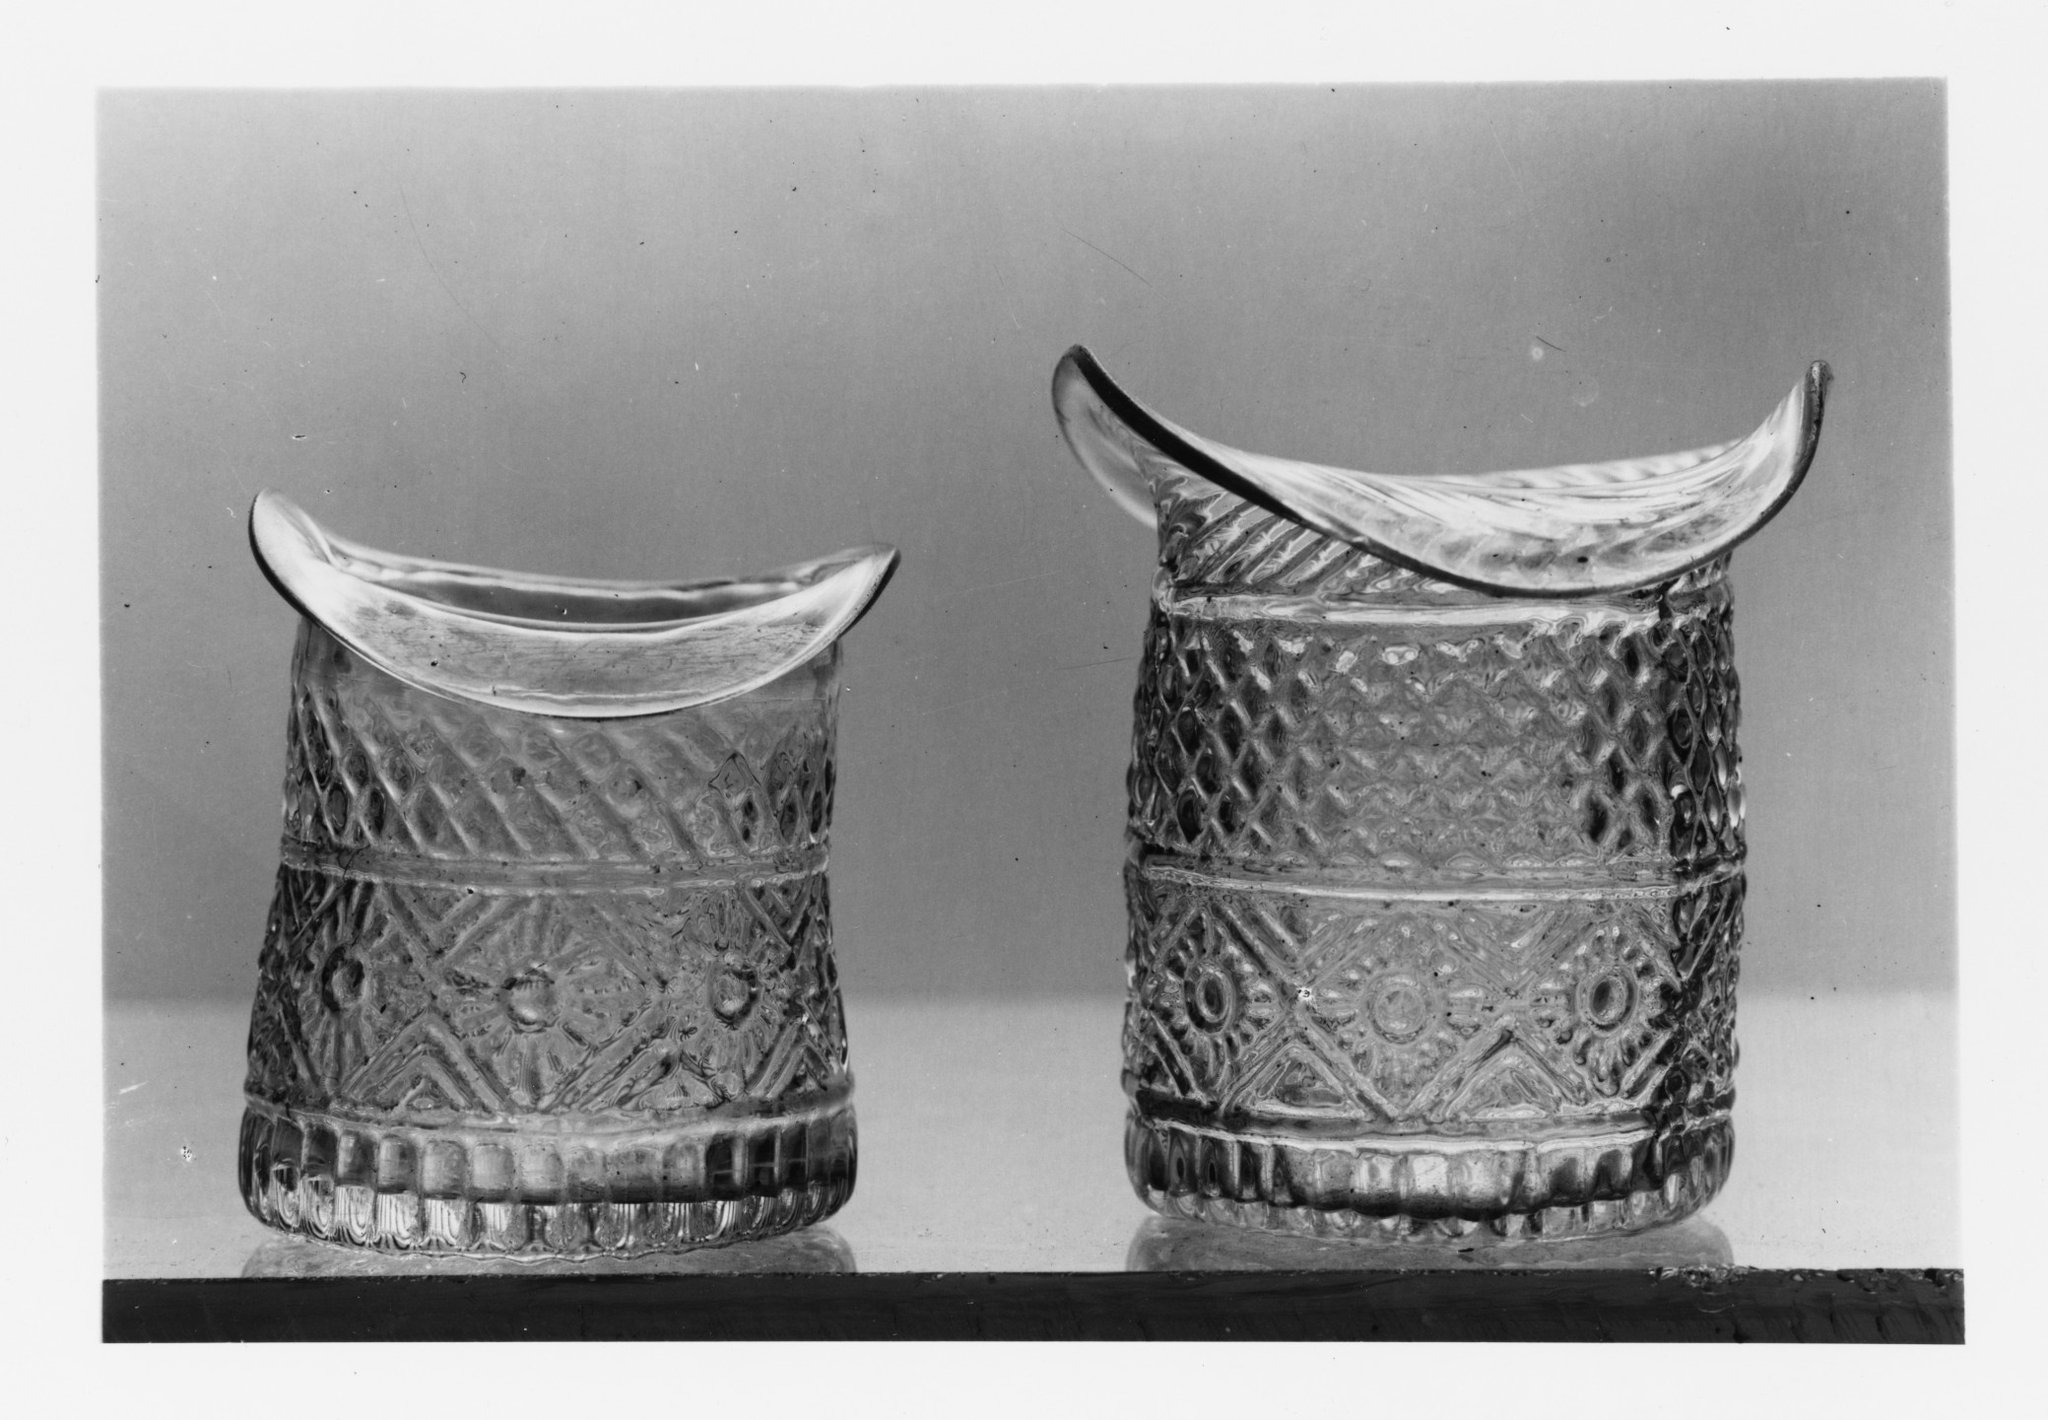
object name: figure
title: Hat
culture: american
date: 1820-1840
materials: glass, lead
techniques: glassblowing, molding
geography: united states